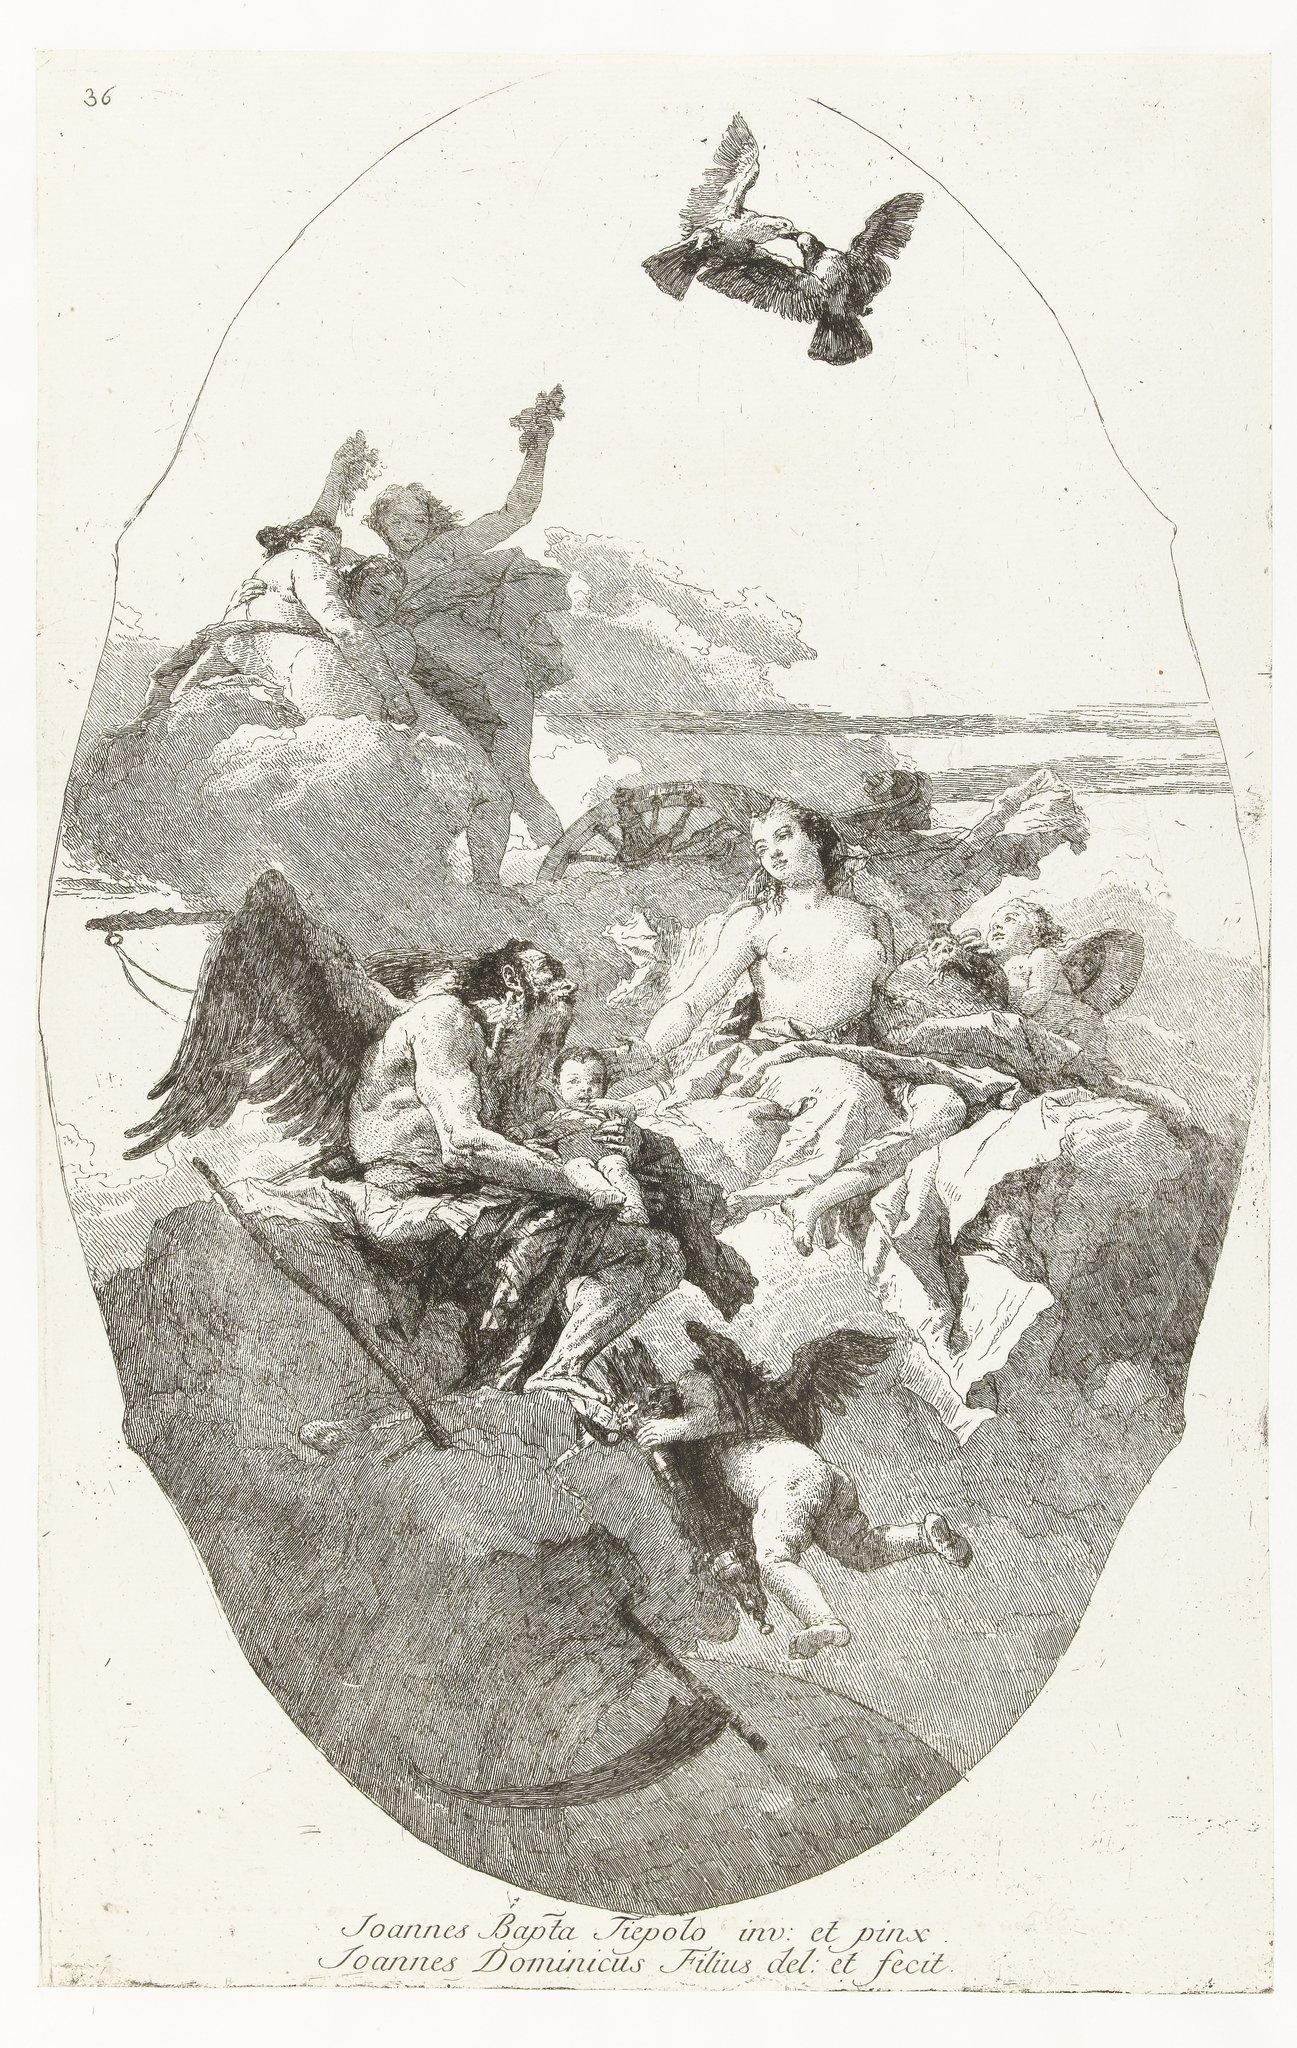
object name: print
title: Allegory with Venus and Time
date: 1758-1760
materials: paper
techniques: etching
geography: venice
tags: father time, man with wings and scythe, venus and cupid (cupid not being mere attribute)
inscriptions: collector's mark: Lugt 2228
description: This etching reproduces a ceiling painting by Giovanni Battista Tiepolo for a gallery in the Palazzo Contarini, a Venetian city palace. The depiction is alternately interpreted as ‘Venus entrusting Cupid to Time’ and ‘The birth of Aeneas’. Given that the child lacks Cupid/ Amor’s usual attributes (bow and arrow), the second interpretation seems more likely.